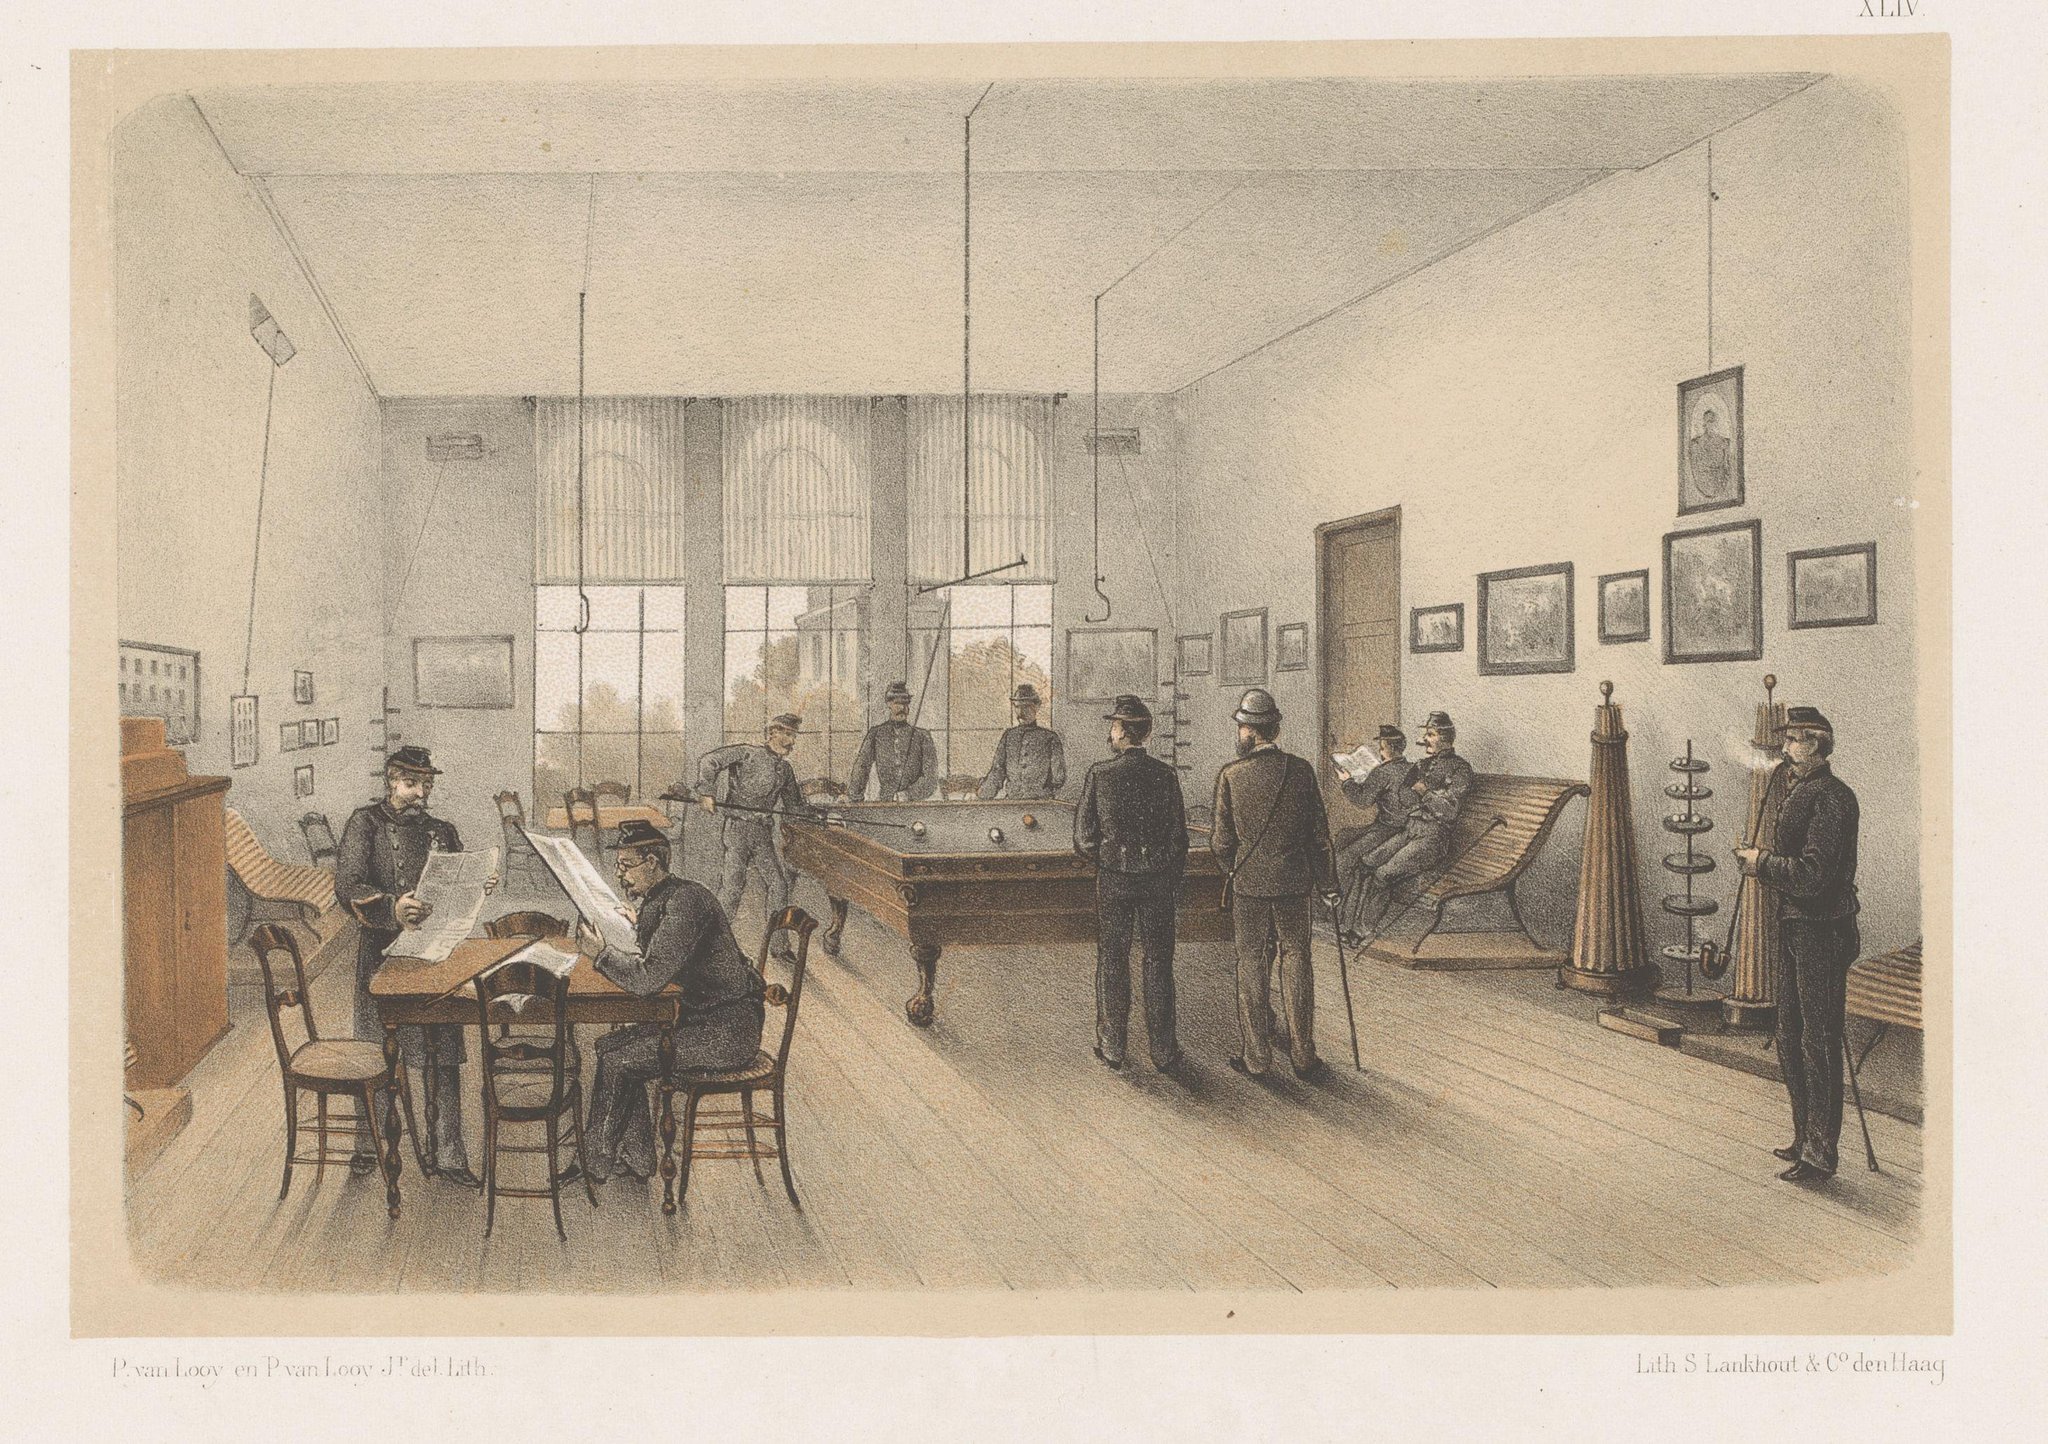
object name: print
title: Militairen in een biljartkamer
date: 1881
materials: paper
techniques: tone lithography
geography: the hague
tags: billiards, pipe ~ tobacco, recreation ~ the soldier off duty, newspaper, news-sheet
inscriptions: collector's mark: Lugt 2228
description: Militairen vermaken zich met het spelen van biljart en het lezen van de krant. Rechts staat een militair een pijp te roken. Genummerd rechtsboven: XLIV.